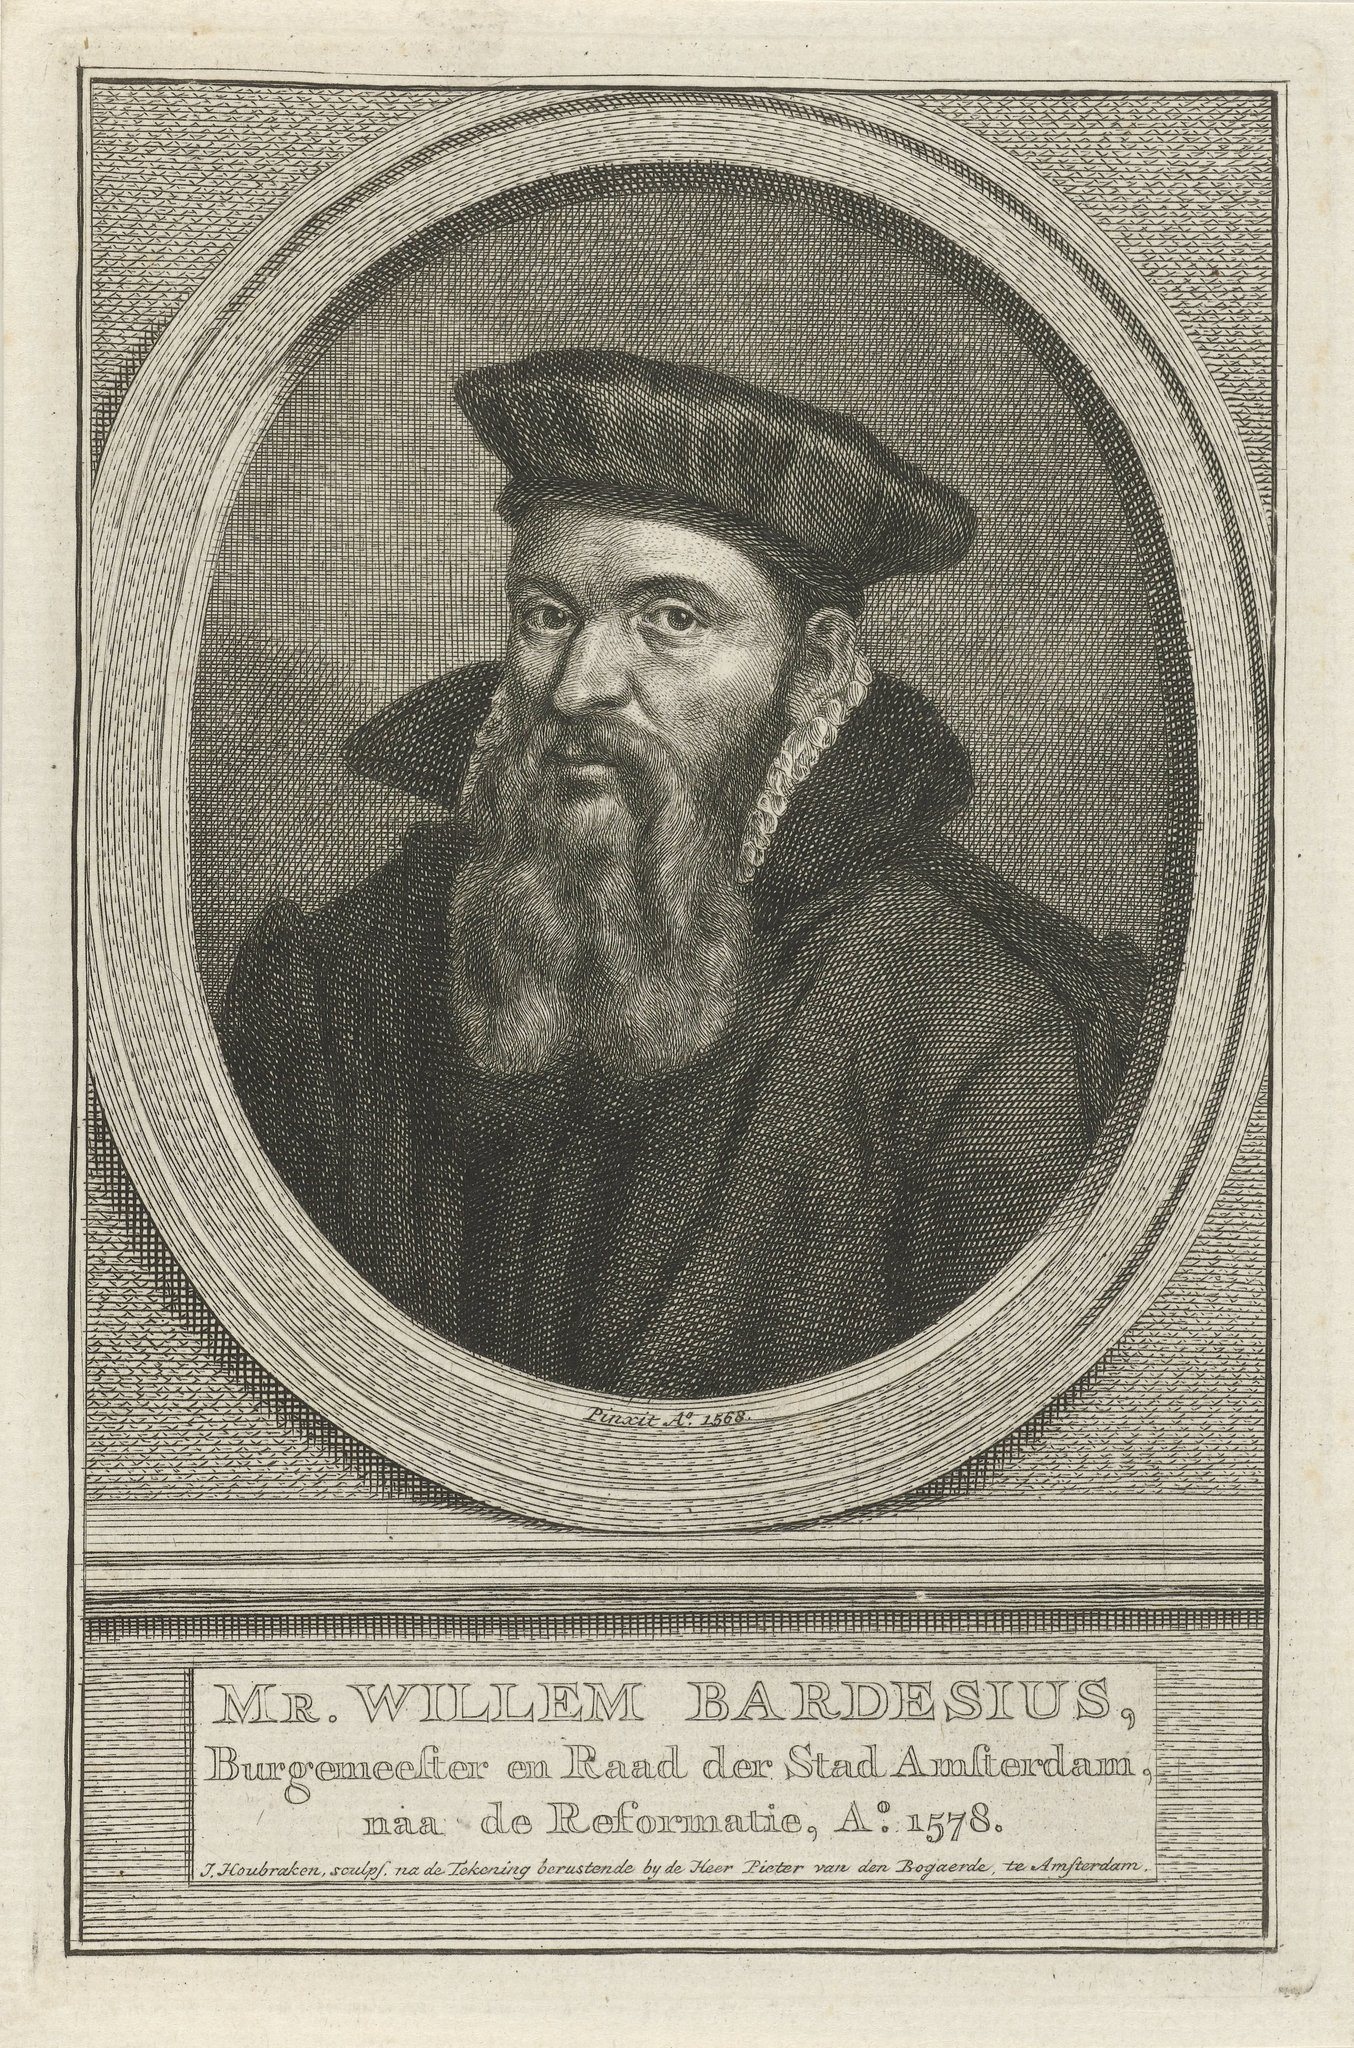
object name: print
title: Portret van Willem Bardes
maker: jacob houbraken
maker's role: draughtsman, print maker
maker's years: 1698-1780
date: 1749-1759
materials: paper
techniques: engraving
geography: amsterdam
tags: alkmaar, willem bardes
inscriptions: collector's mark: Lugt 2228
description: Prent oorspronkelijk bedoeld voor: Jan Wagenaar, Vaderlandsche historie, vervattende de geschiedenissen der nu Vereenigde Nederlanden, inzonderheid die van Holland (...), 21 delen. Amsterdam, Isaak Tirion, 1749-59.